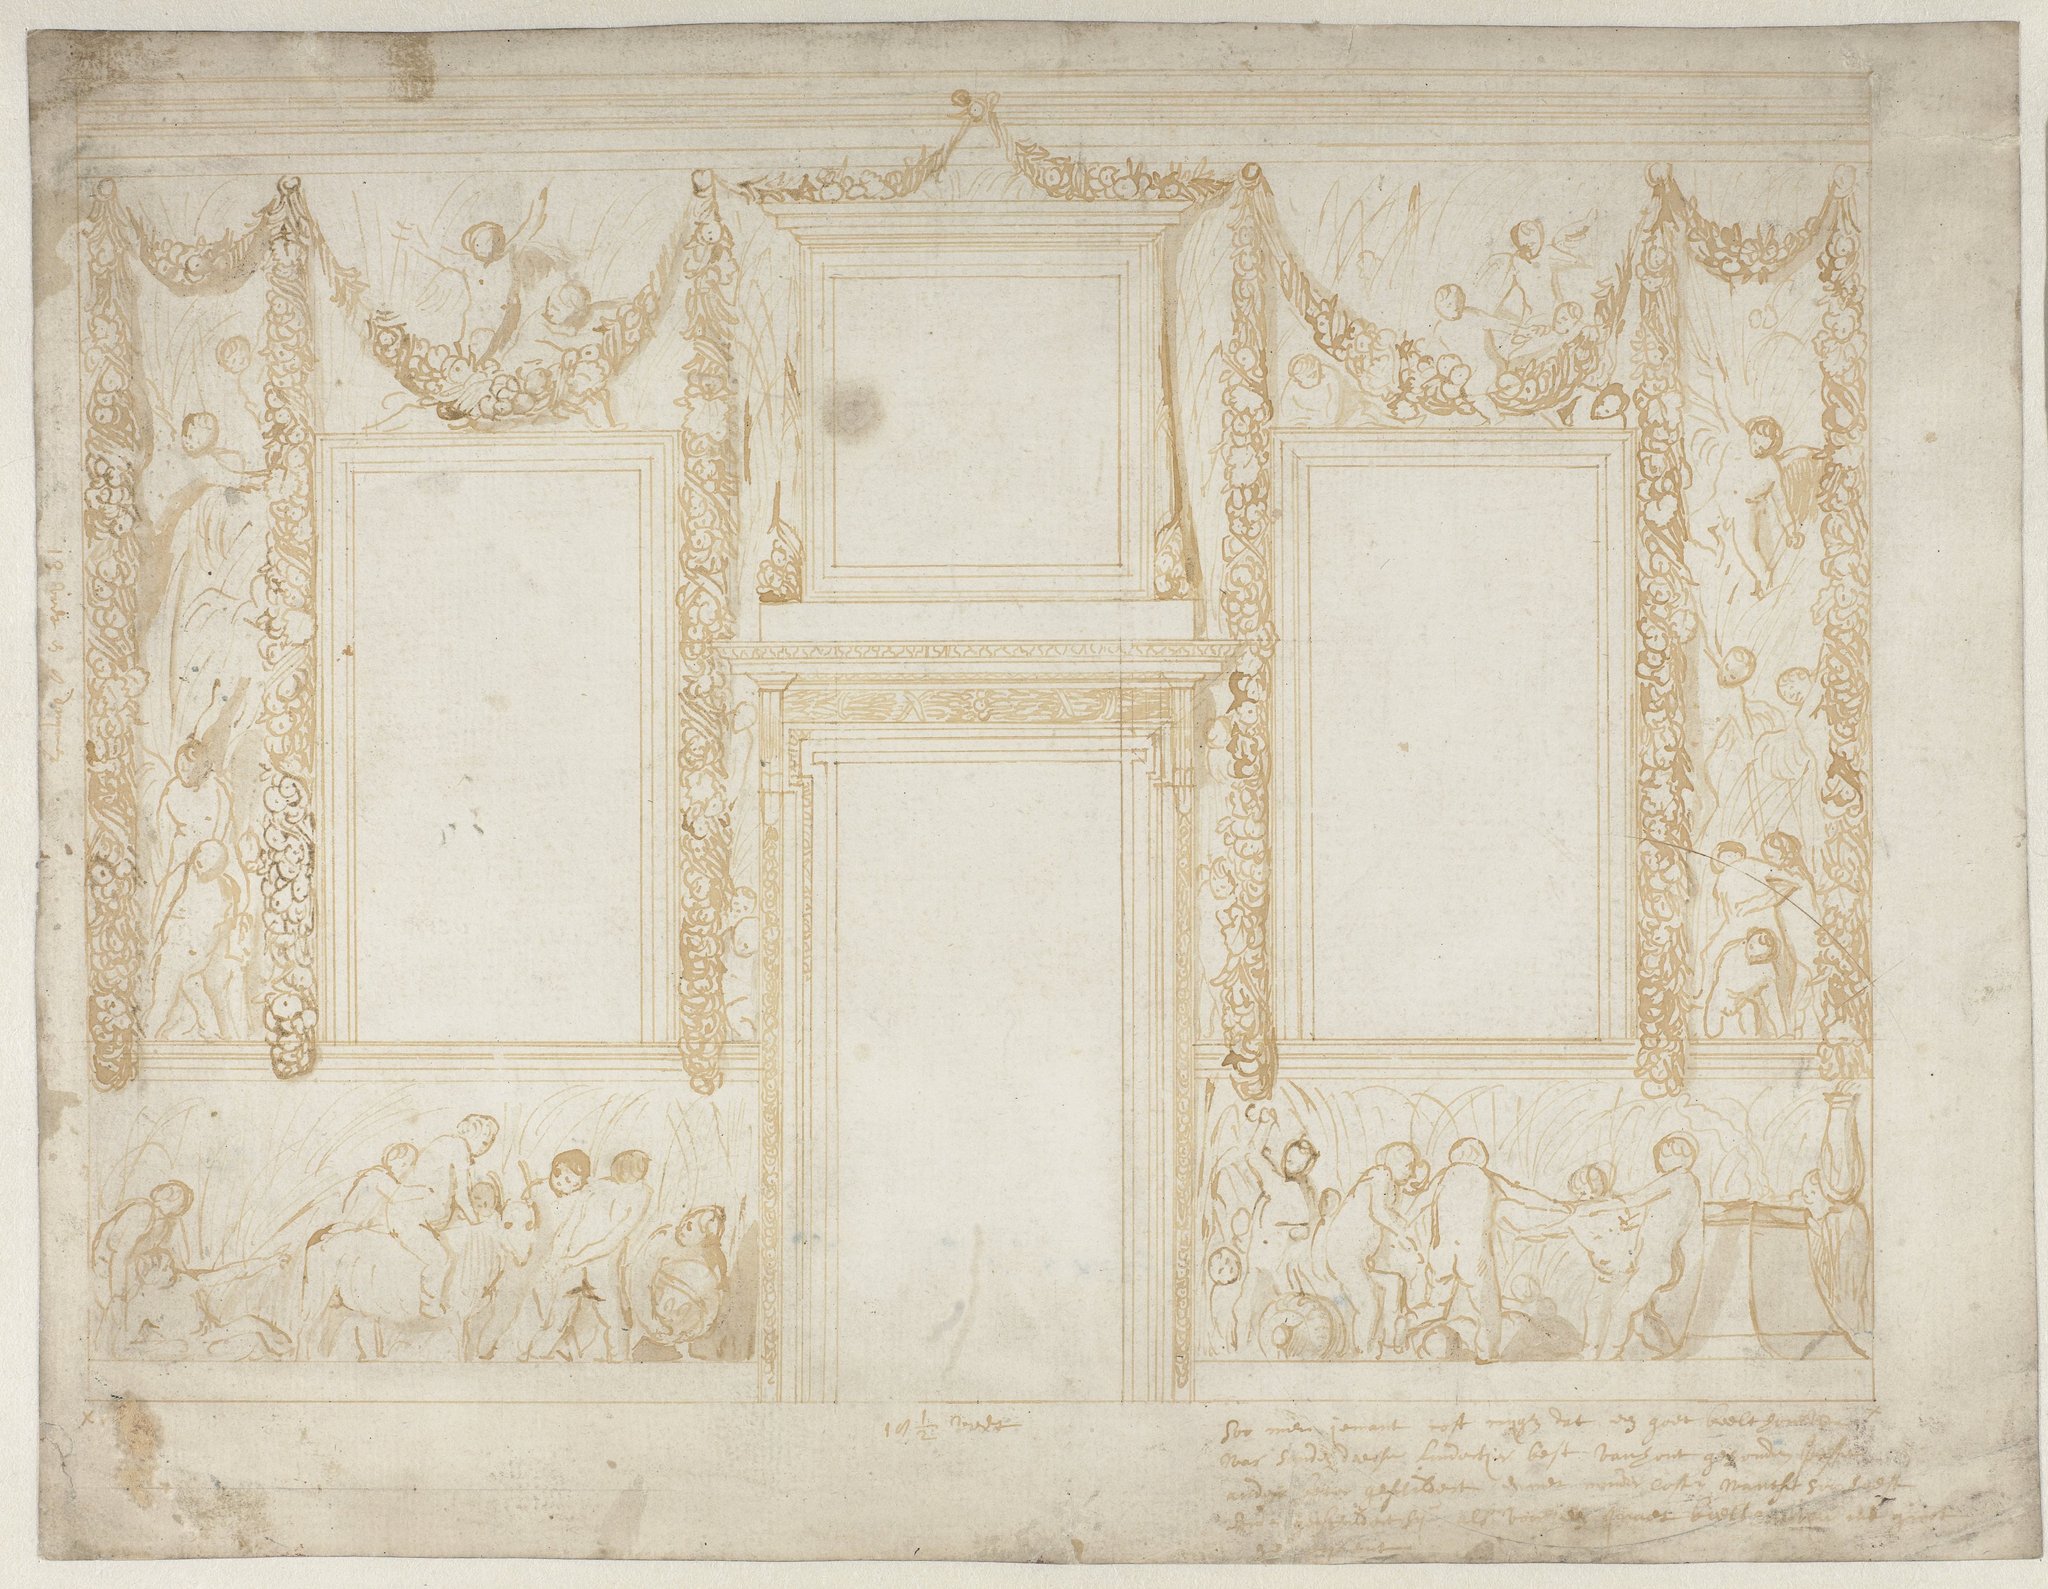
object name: drawing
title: Ontwerp voor decoraties op een muur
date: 1600-1699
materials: ink, paper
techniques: brush, pen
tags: children's bacchanal, surface decorations ~ architecture, wall-covering, ornament ~ festoon, garland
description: Ontwerp voor de decoraties op een muur rond een deur met putti en guirlandes.